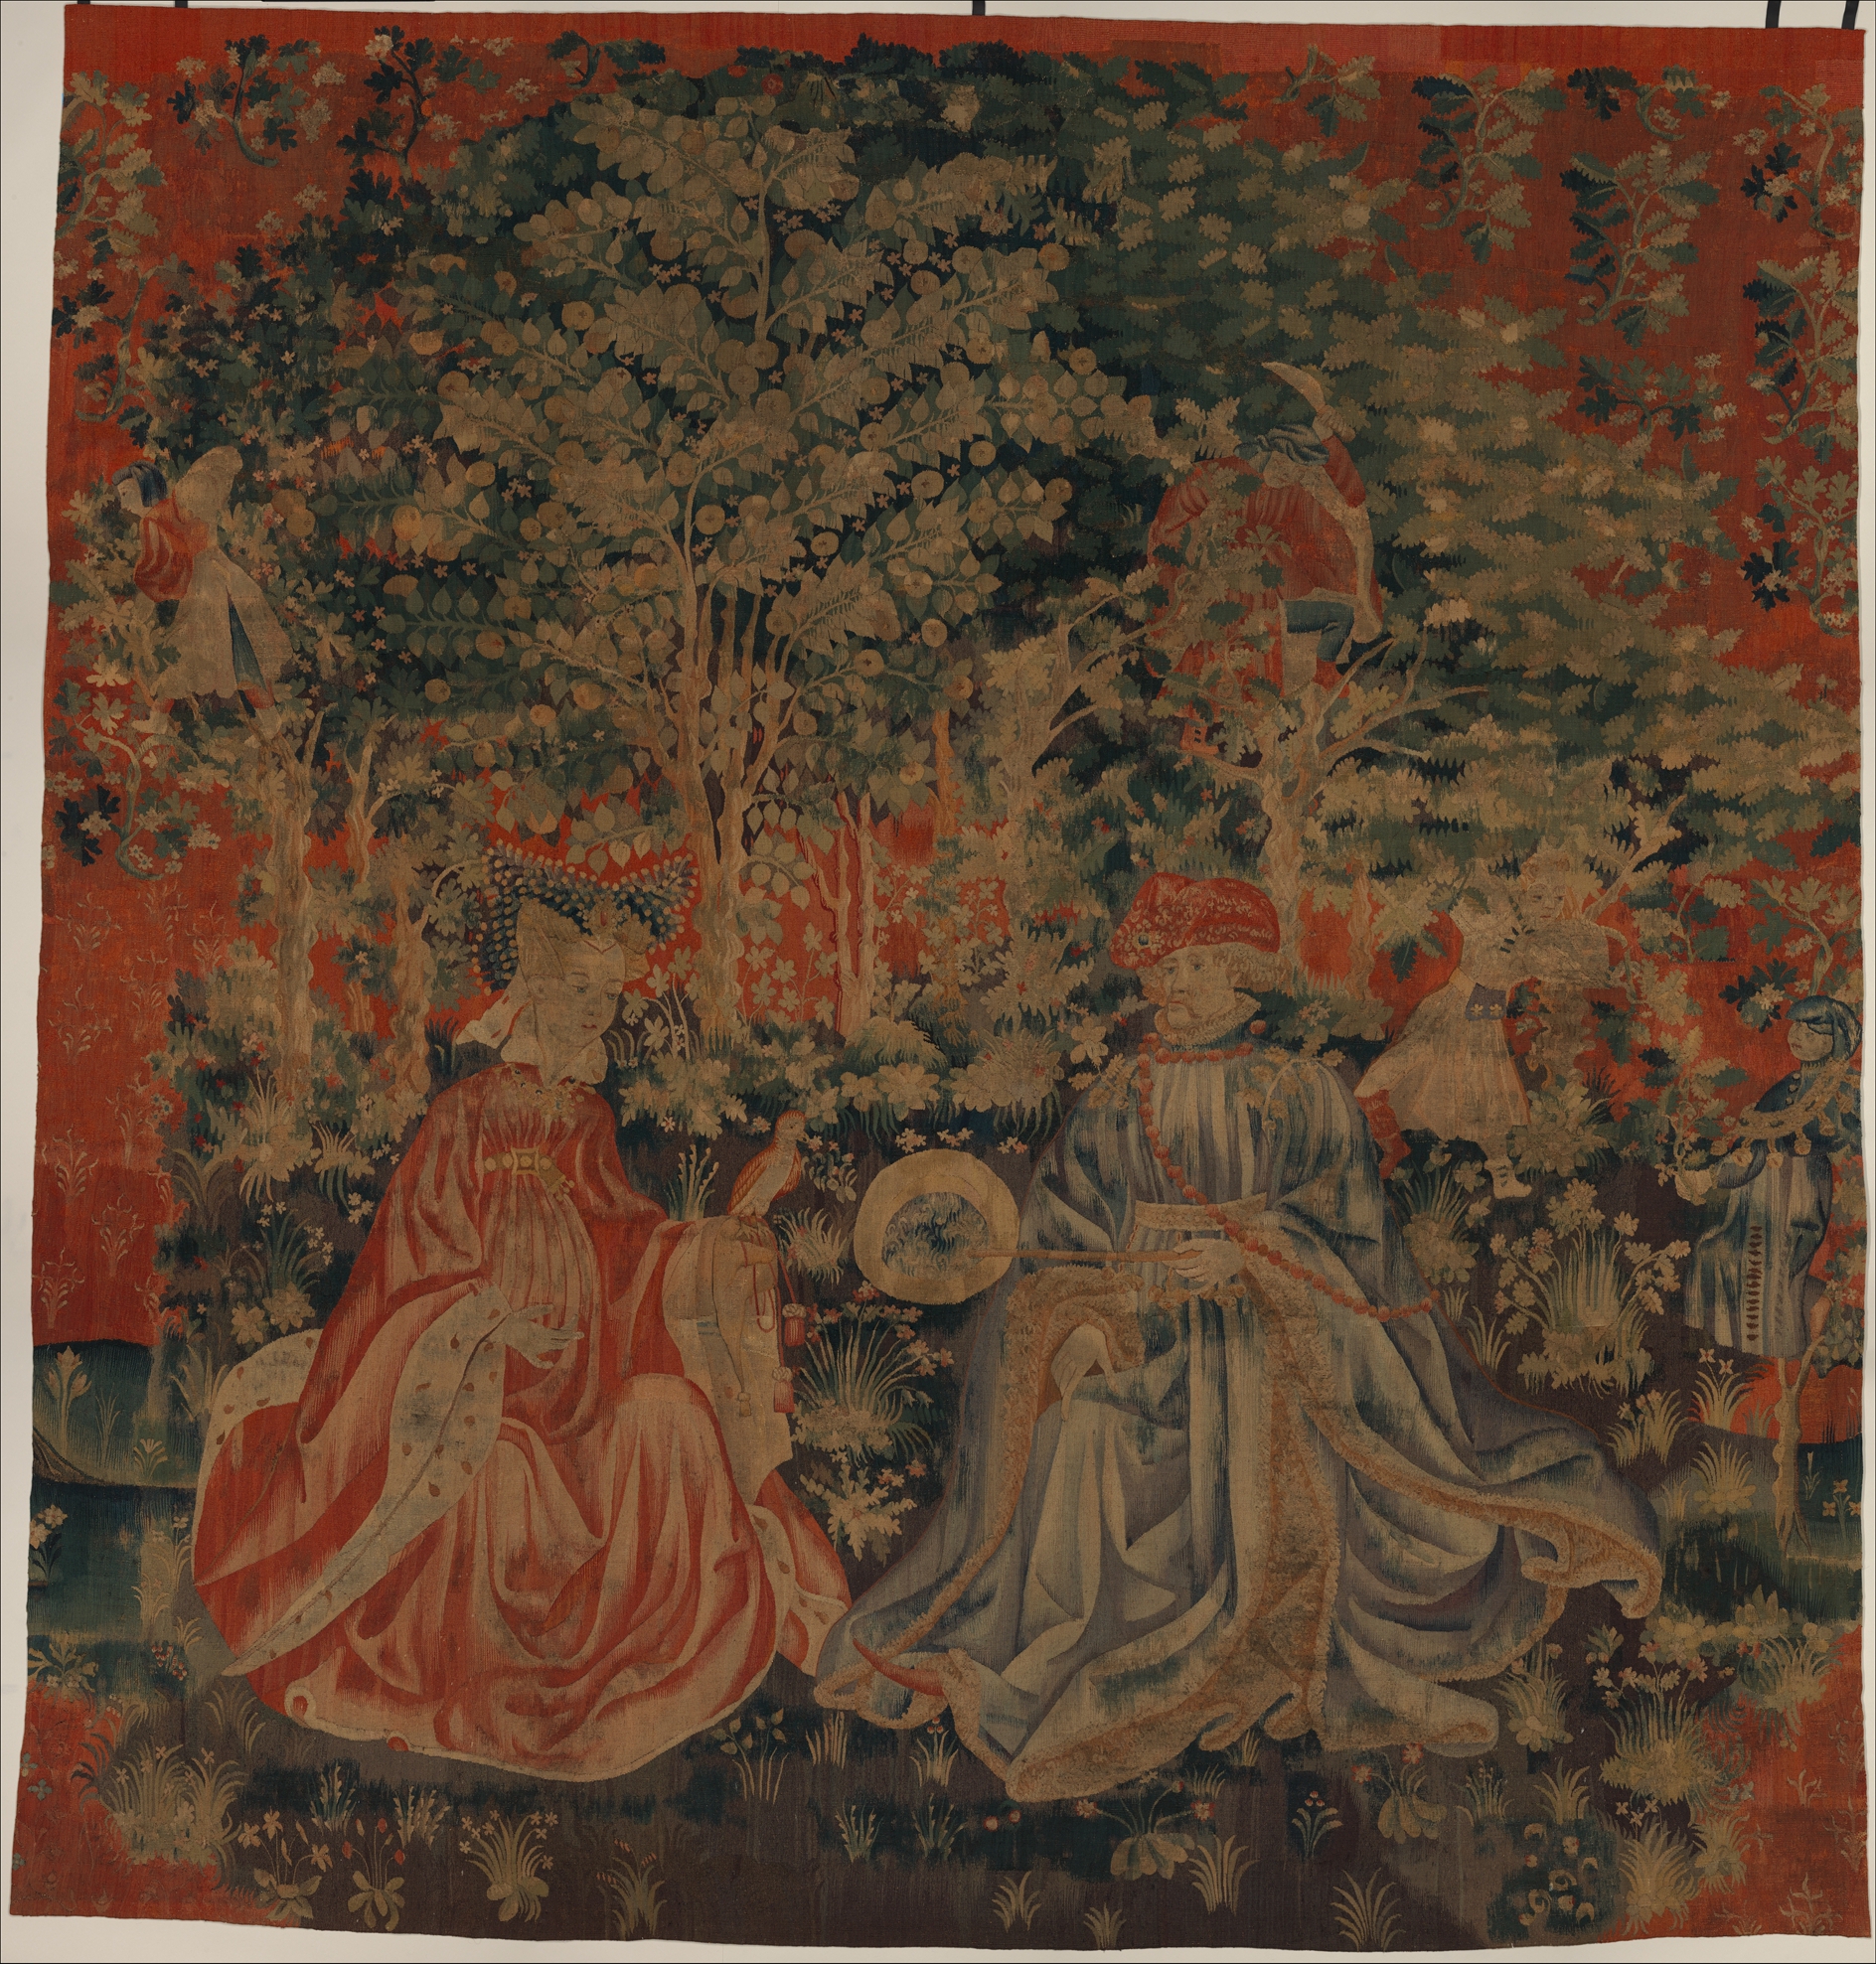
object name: tapestry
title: The Falcon's Bath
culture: south netherlandish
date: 1400-1415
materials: wool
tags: falcons,men,women,trees